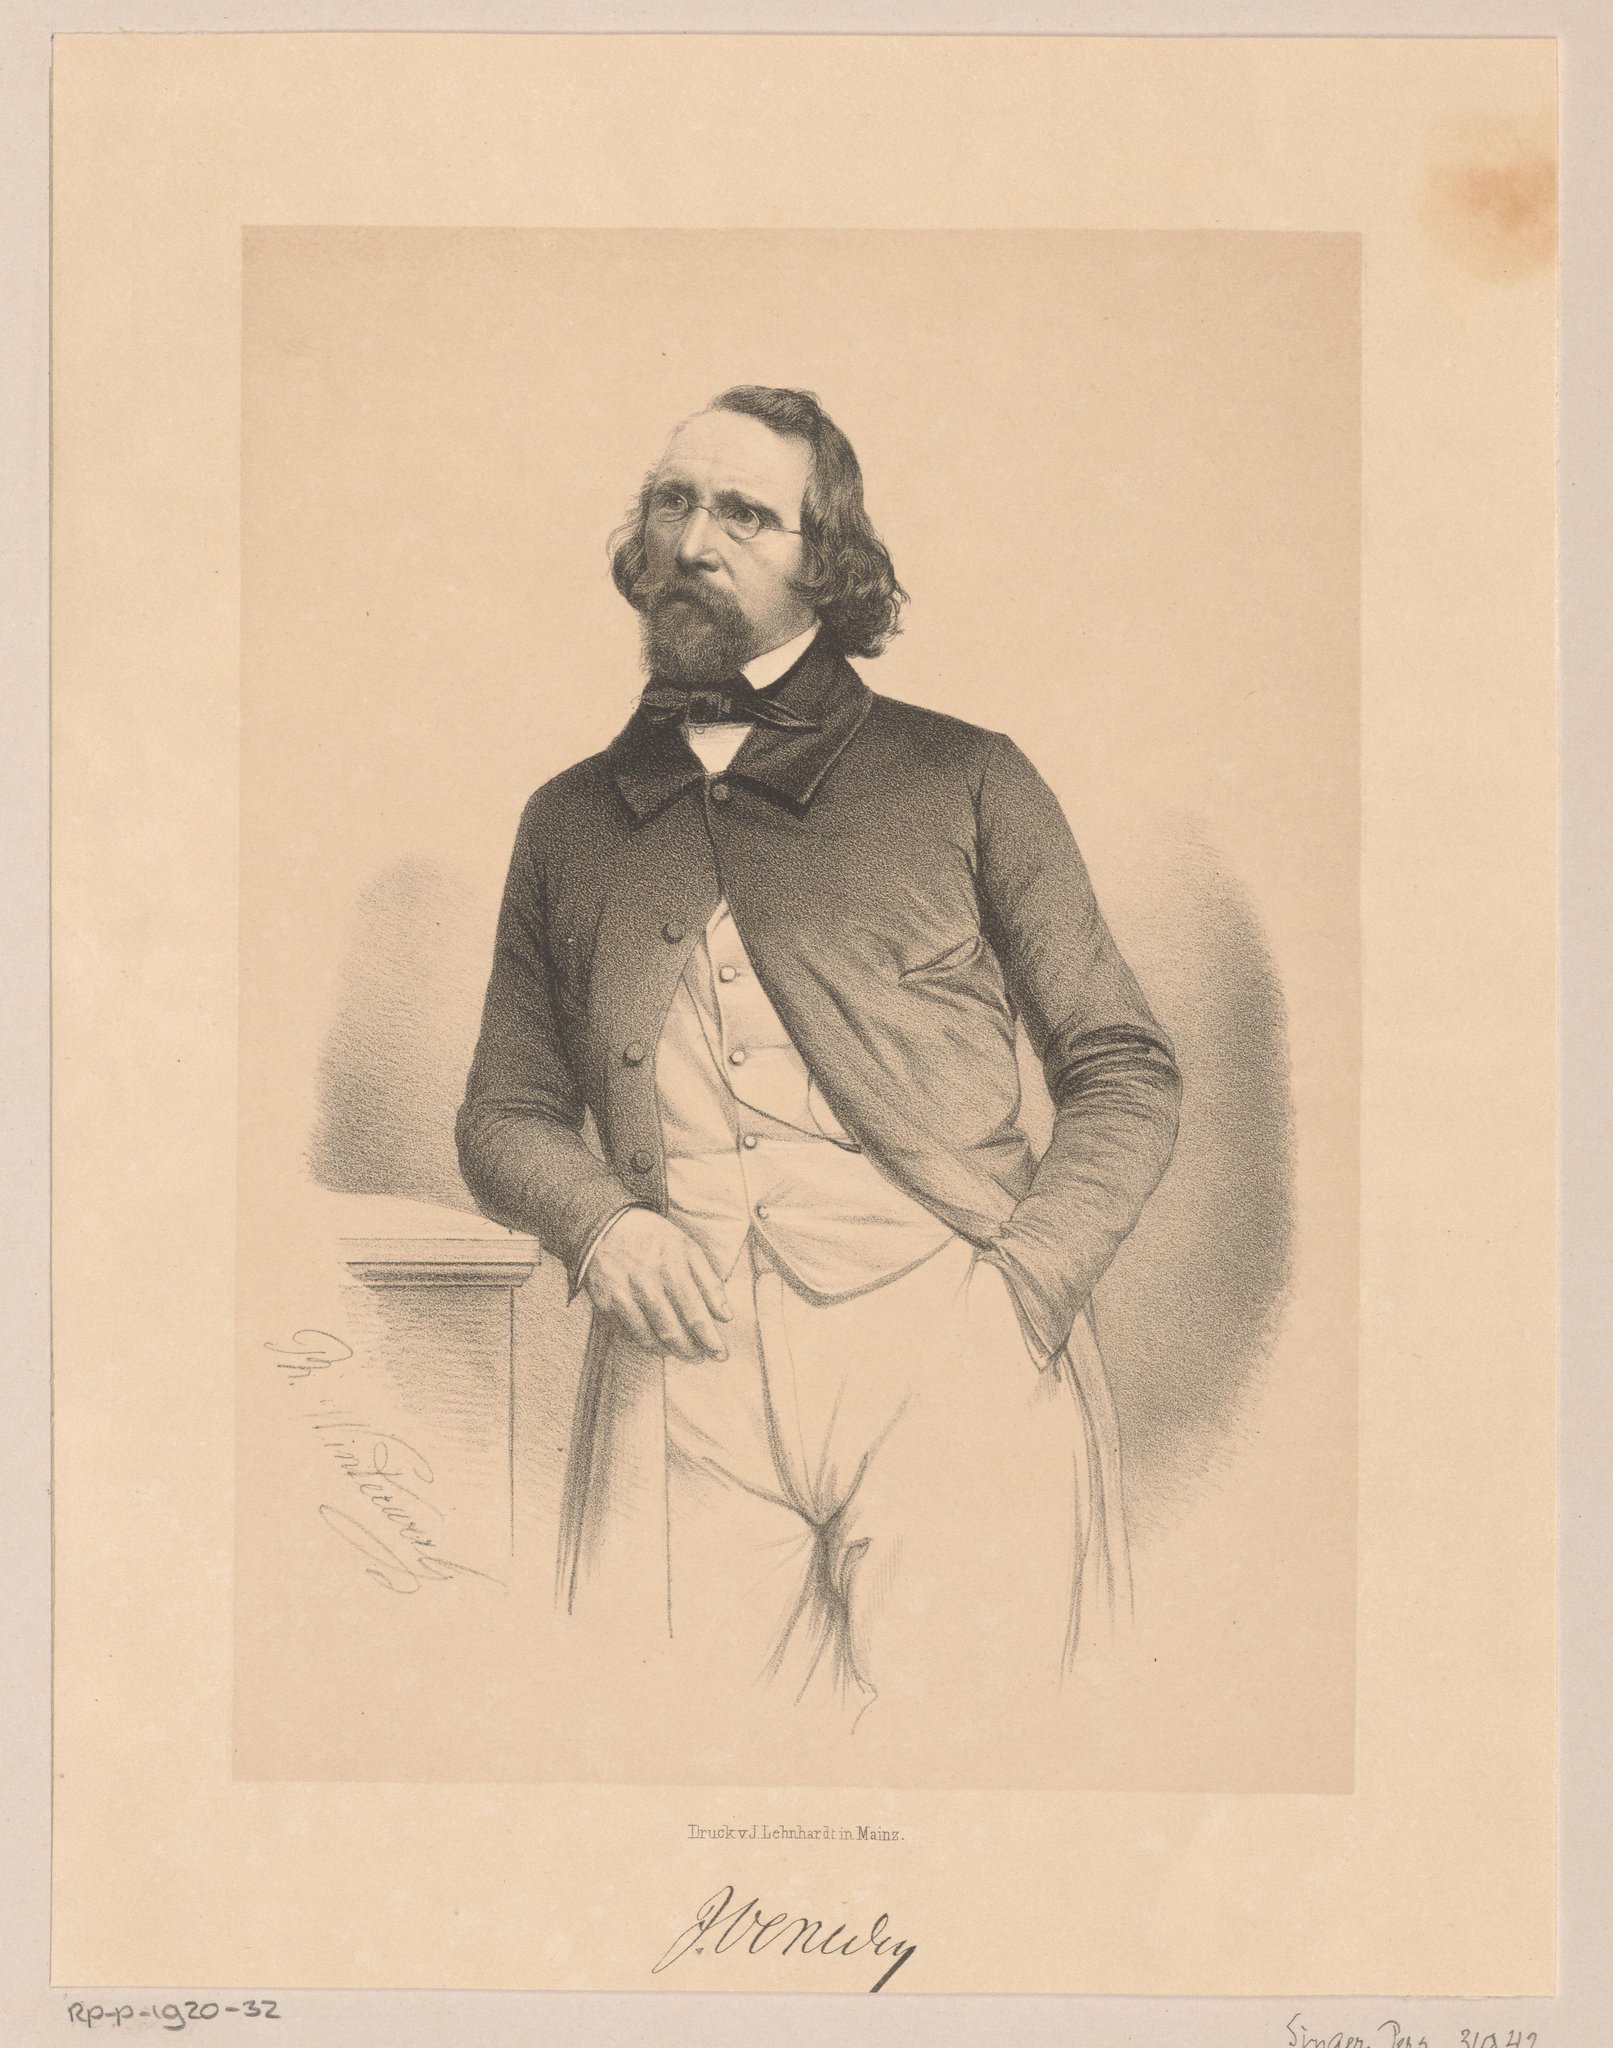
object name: print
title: Portret van Jakob Venedey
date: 1849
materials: paper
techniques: tone lithography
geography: frankfurt am main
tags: cologne, politician, historical persons, portrait of a writer, politician, e.g. party leader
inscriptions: collector's mark: Lugt 2228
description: Prent behoort waarschijnlijk tot de serie 'Album der deutschen National-Versammlung'. Deze serie bestaat uit circa 54 portretten die onder andere zijn vervaardigd door Philipp Winterwerb en Heinrich Hasselhorst naar foto's van Seib. Deze serie is in 1849 uitgegeven door Carl Christian Jügel.